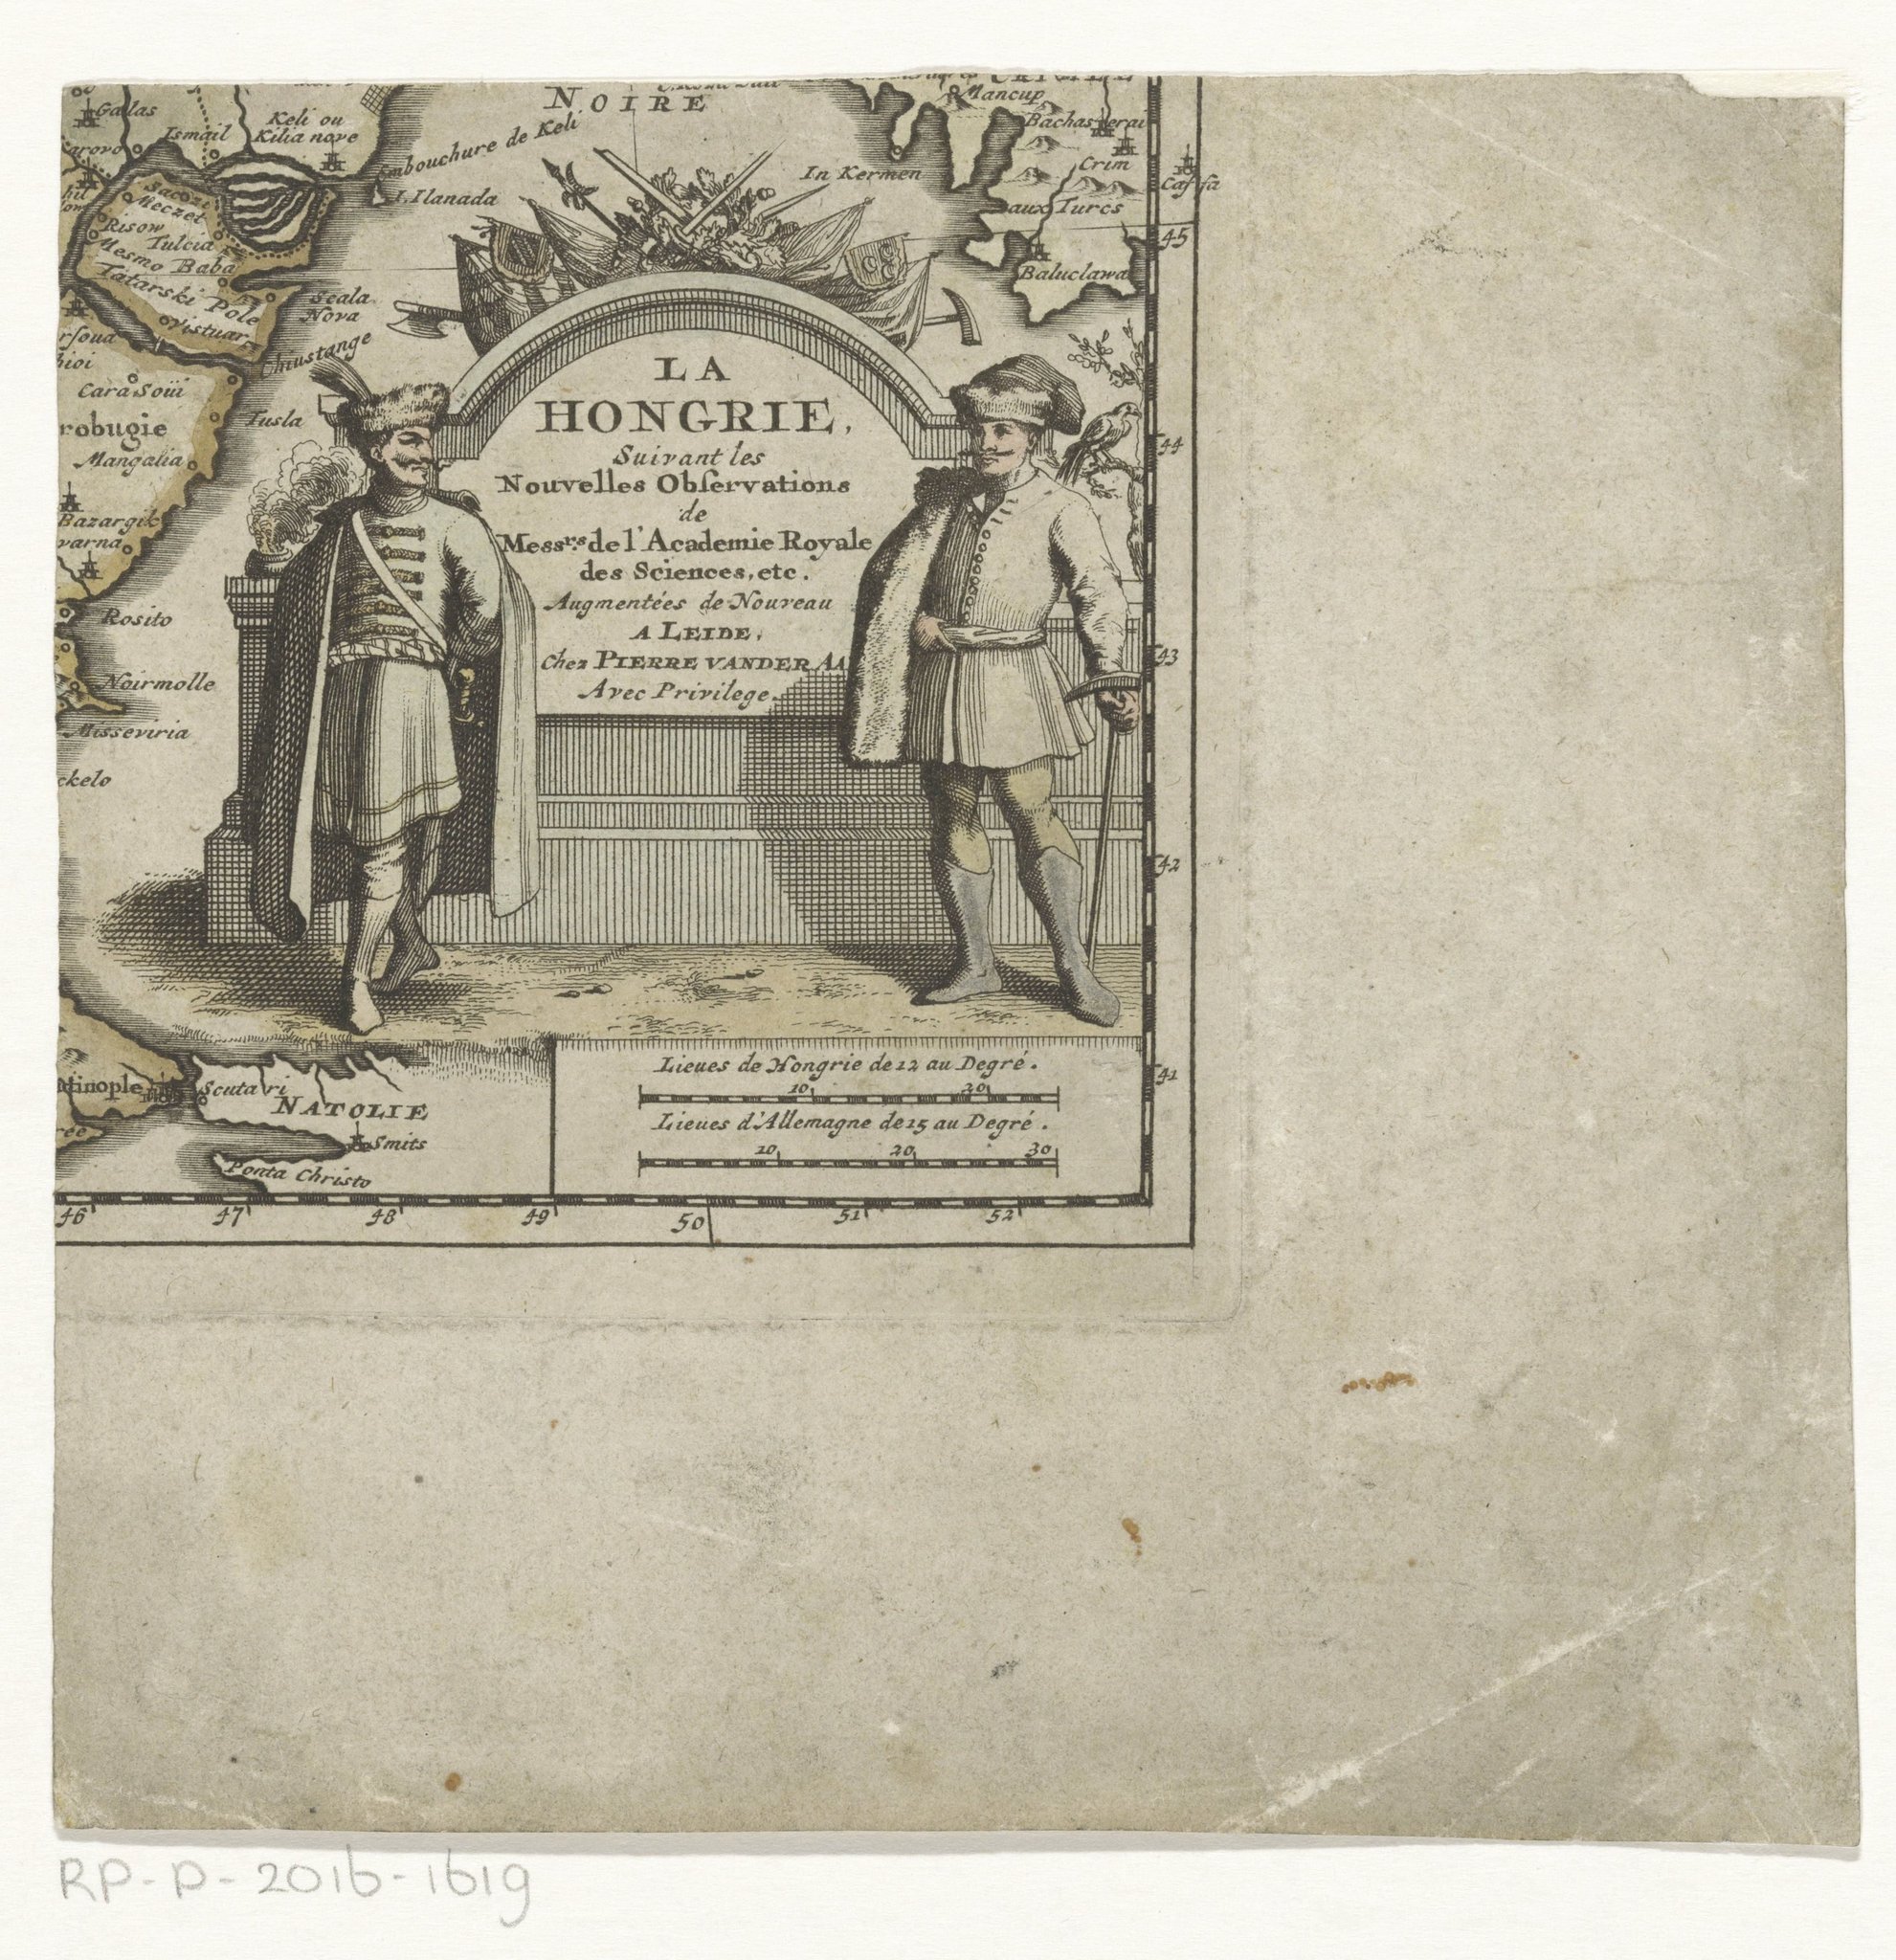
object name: print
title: La Hongrie, Suivant les Nouvelles Observations de Messrs de l'Academie Royale des Sciences (...)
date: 1690-1710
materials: paper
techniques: etching, hand coloring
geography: leiden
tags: europeans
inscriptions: collector's mark: Lugt 2228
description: Twee Hongaarse mannen met muts en mantel staan voor een tablet met titel. Boven het tablet vlaggen, wapens en een laurierkrans. Detail van een kaart van Hongarije.